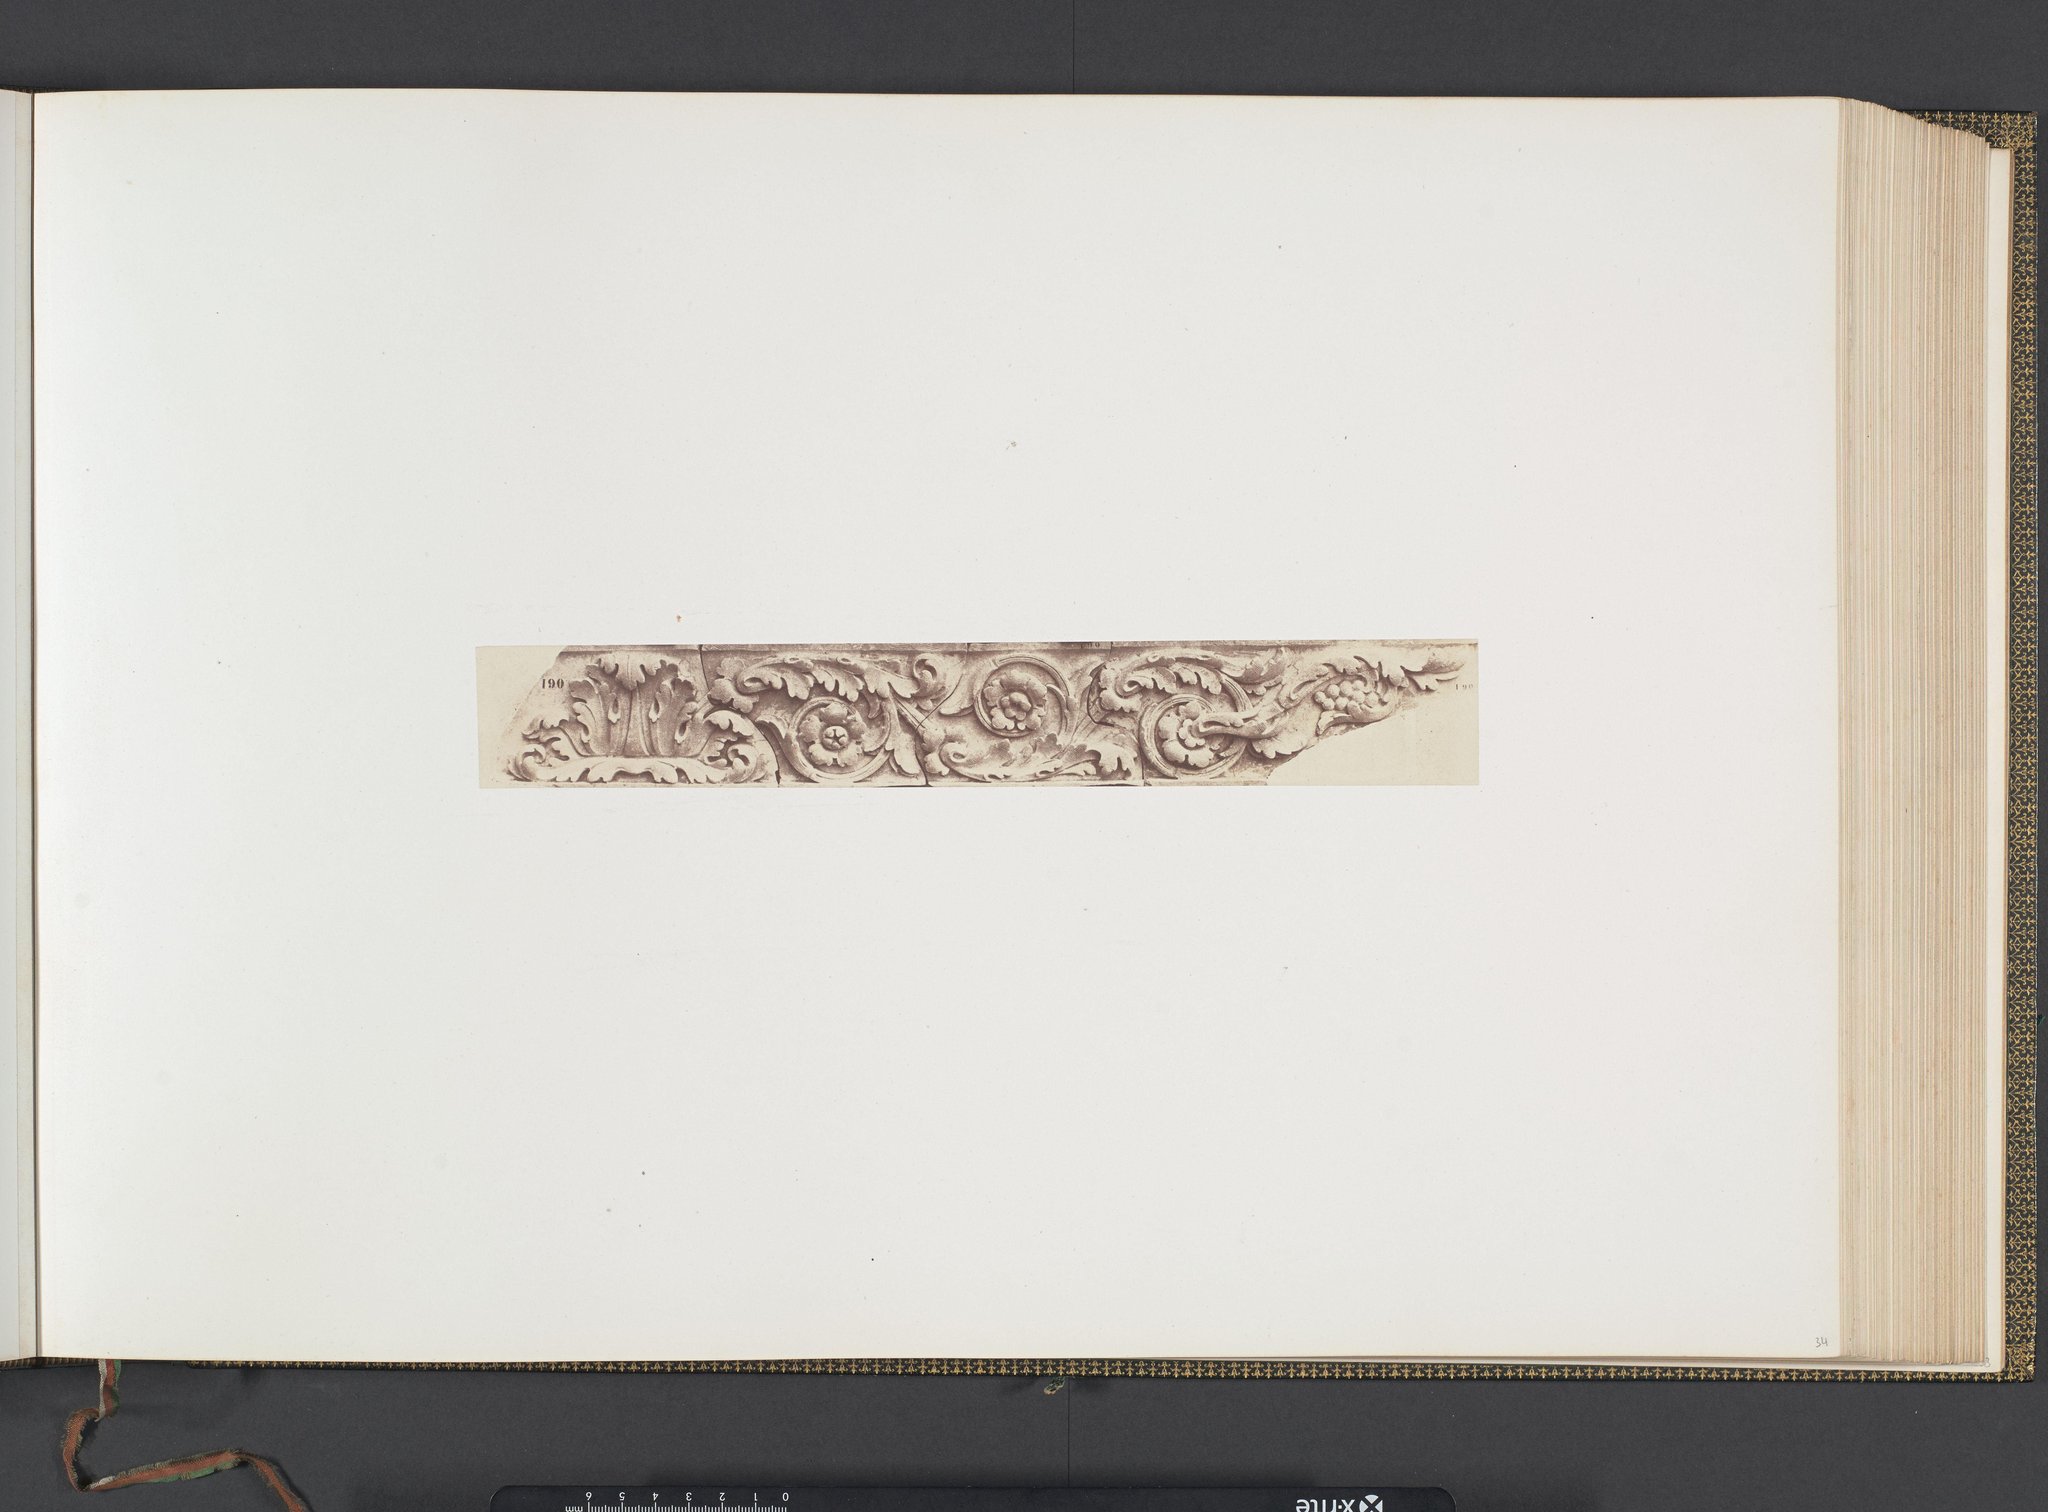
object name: album leaf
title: Detail van een gipsmodel voor de versiering van de zolderverdieping van het Pavillon de Turgot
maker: édouard denis baldus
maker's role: fotograaf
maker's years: 1813-1889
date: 1857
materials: paper, photographic support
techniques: salted paper print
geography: paris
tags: permanent exhibition, museum, ornamenting, decorating ~ applied arts, paris, tuileries palace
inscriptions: number: ‘190’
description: Onderdeel van Réunion des Tuileries au Louvre 1852-1857, album 1.